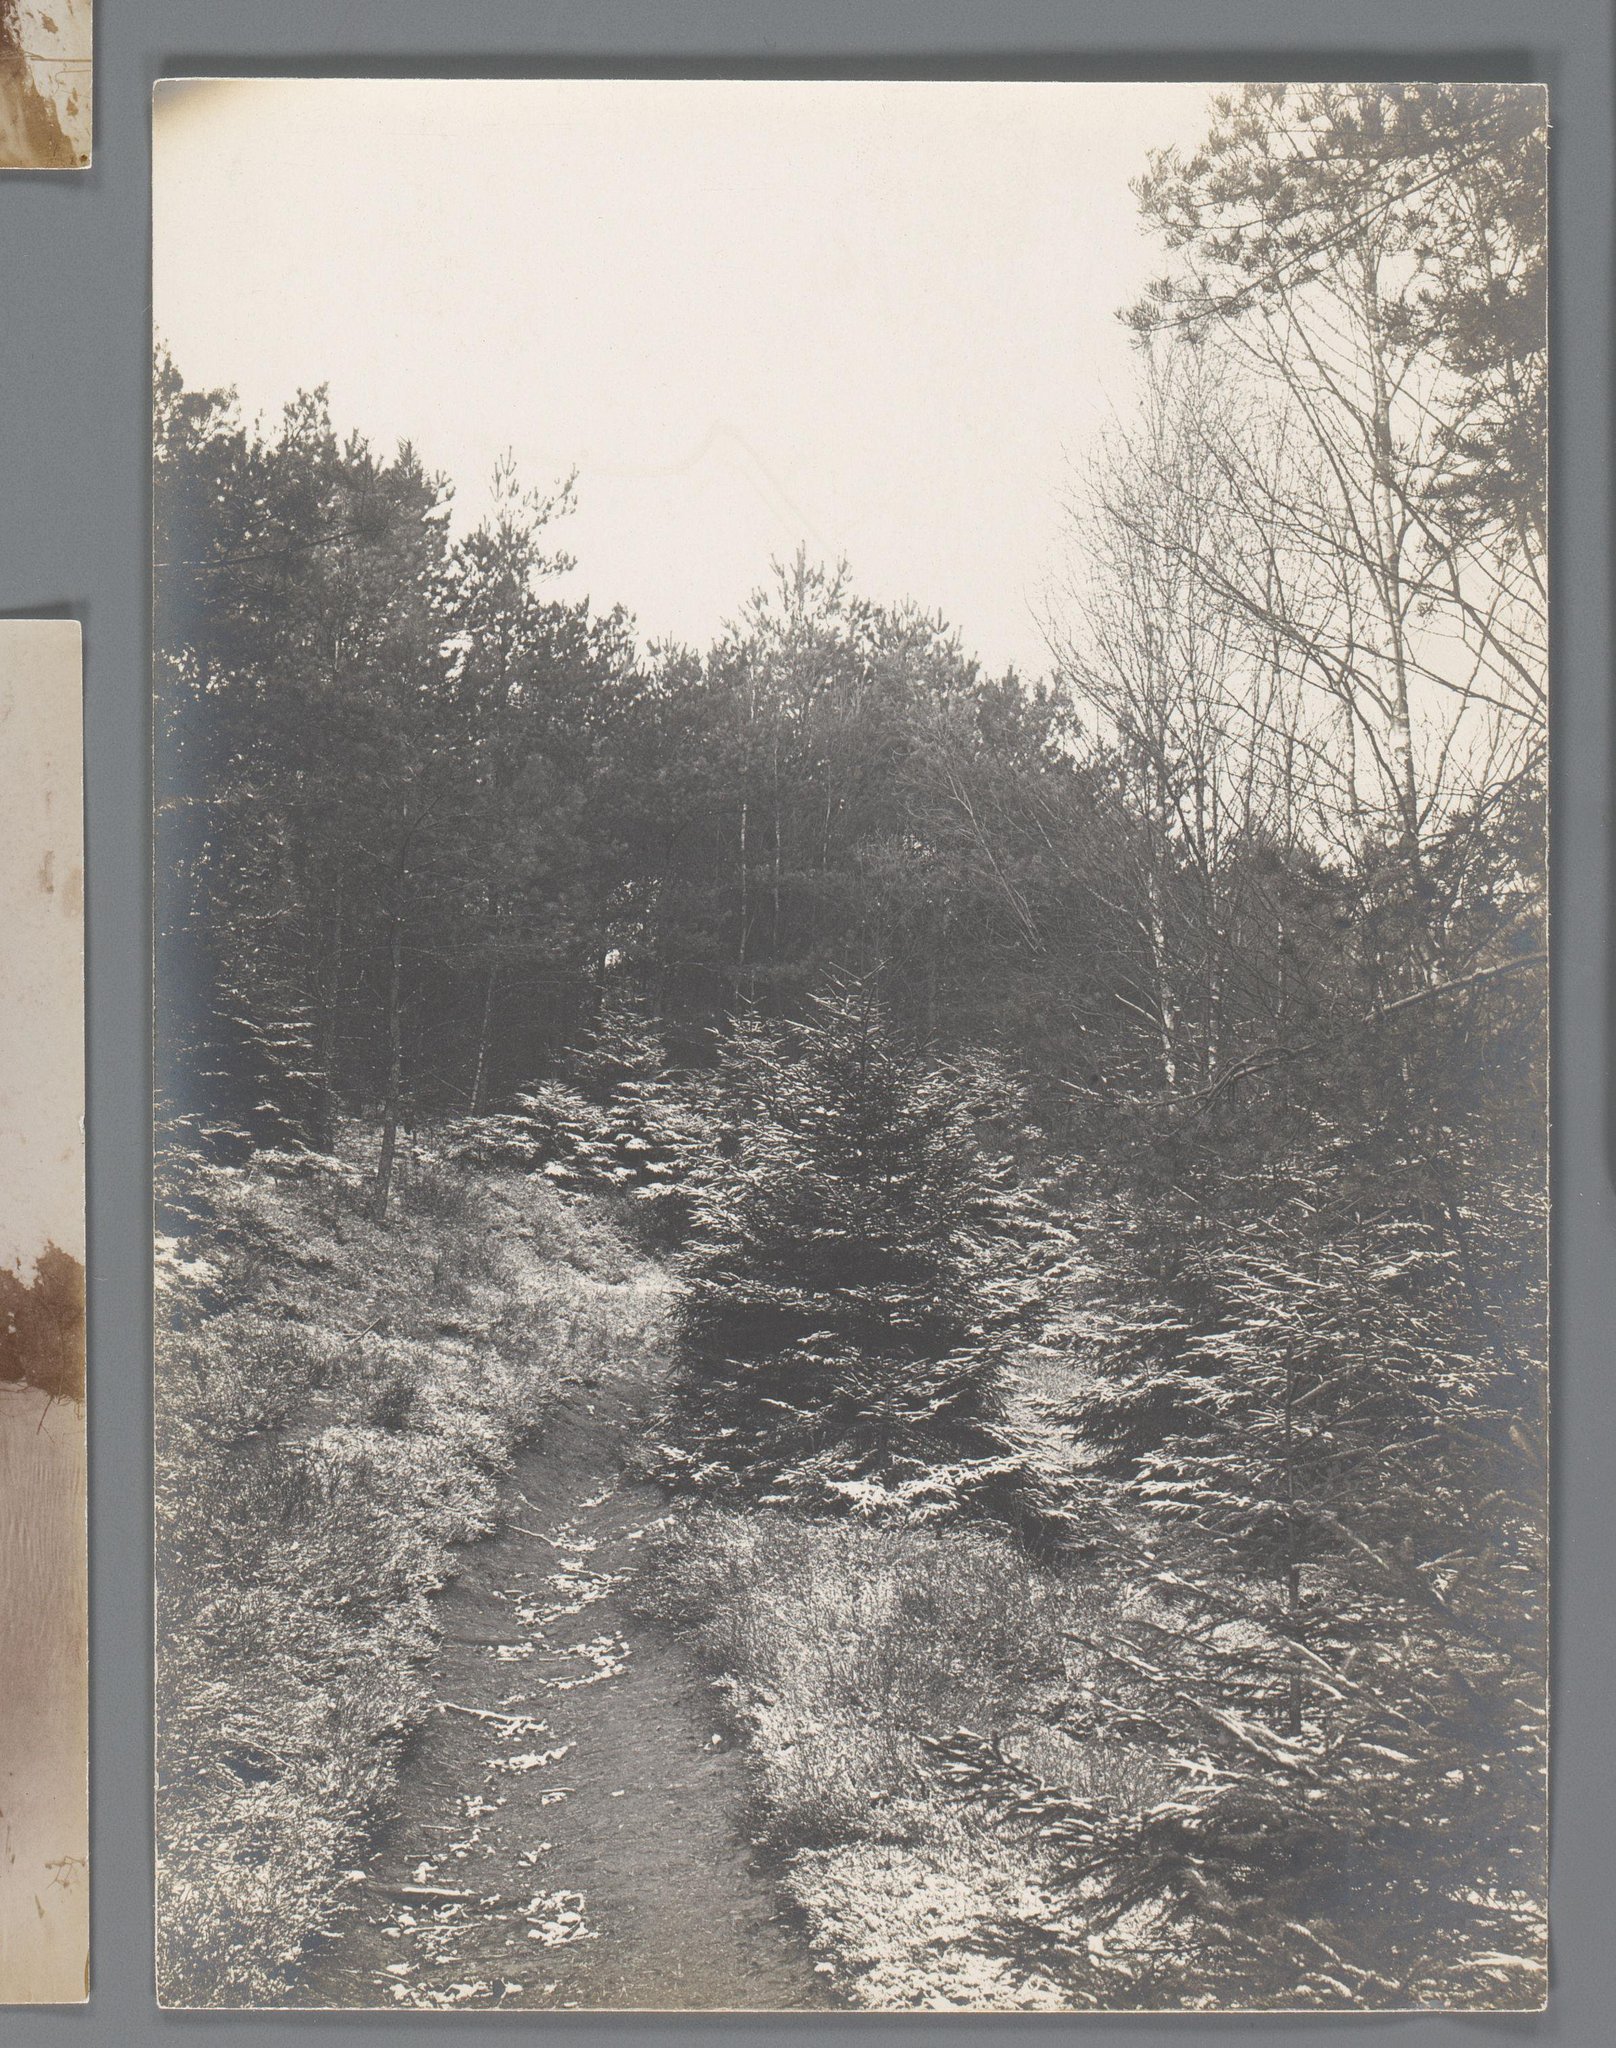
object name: photograph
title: Besneeuwd boslandschap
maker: willem de jong (fotograaf)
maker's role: arts, fotograaf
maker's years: 1864-1918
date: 1895-1918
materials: paper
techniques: gelatin silver print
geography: netherlands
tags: forest, wood, forest path or lane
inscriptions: inscription: ‘foto Willem de Jong’